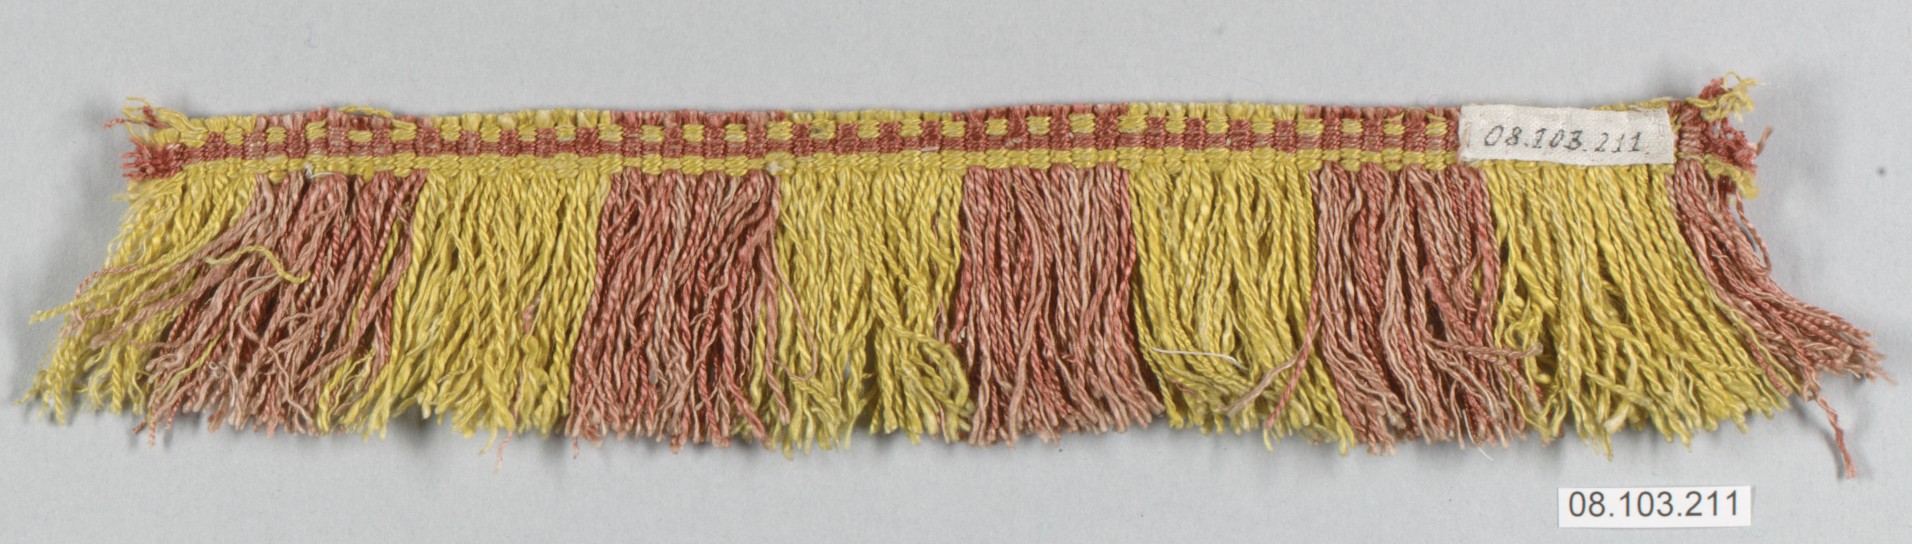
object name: fringe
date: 1701-1800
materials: cotton